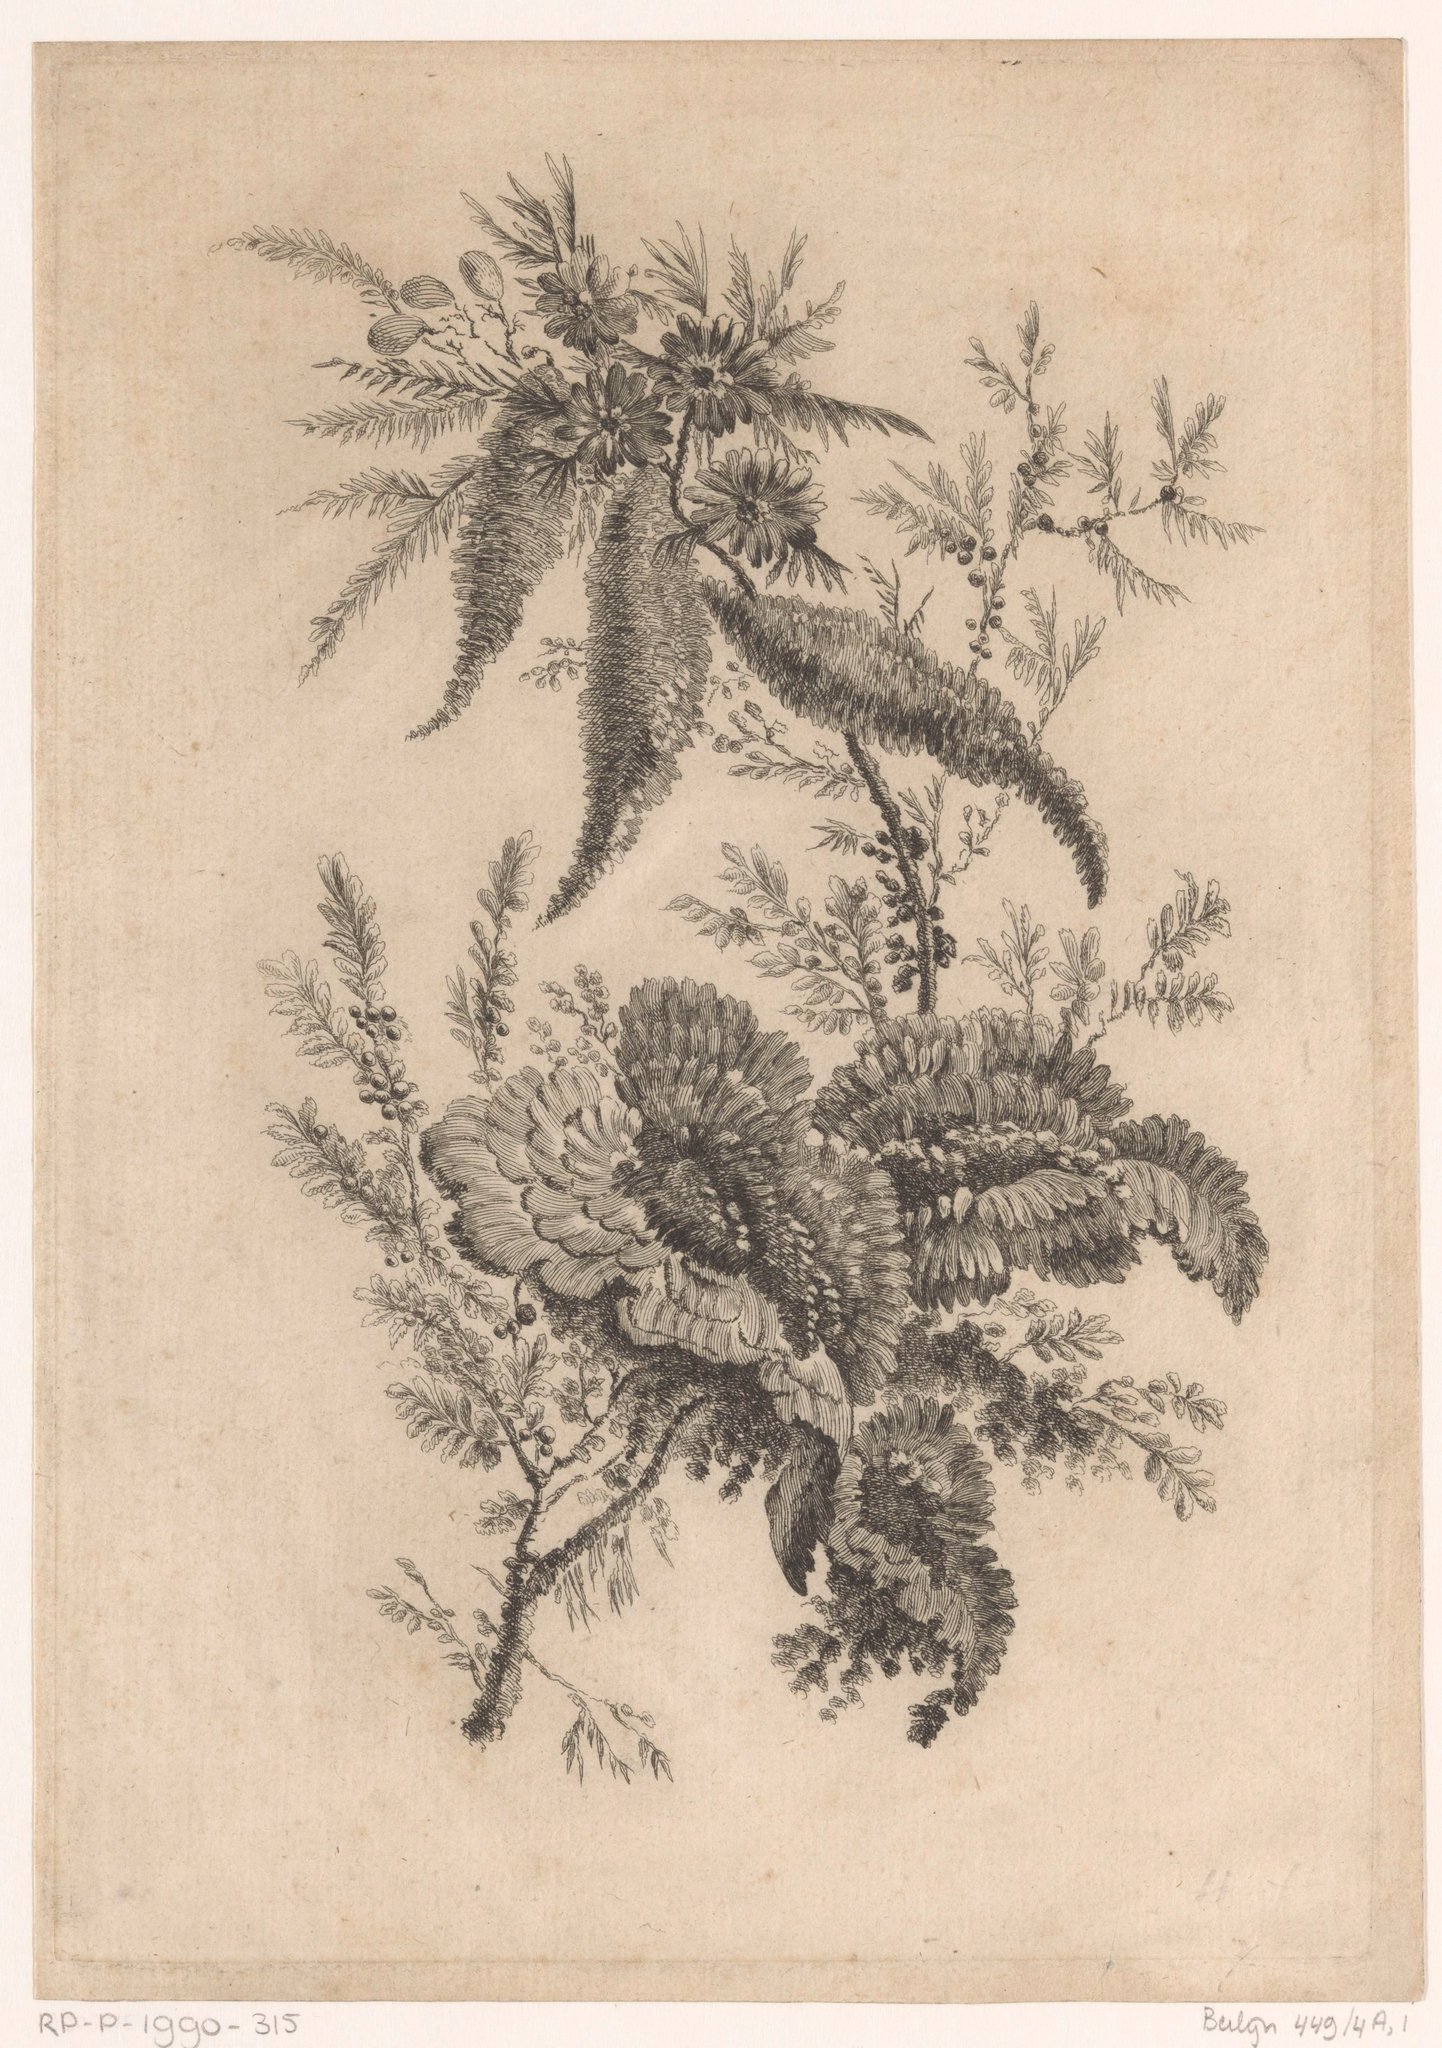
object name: ornament print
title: Recueil De Nouvelles Fleurs De Goût; Pour la Manufacture des Etoffes de Perse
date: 1755-1775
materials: paper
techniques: etching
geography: paris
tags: flowers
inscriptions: collector's mark: Lugt 2760, collector's mark: Lugt 2228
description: Tak met wilde roosachtige bloemen en kleine bessen.